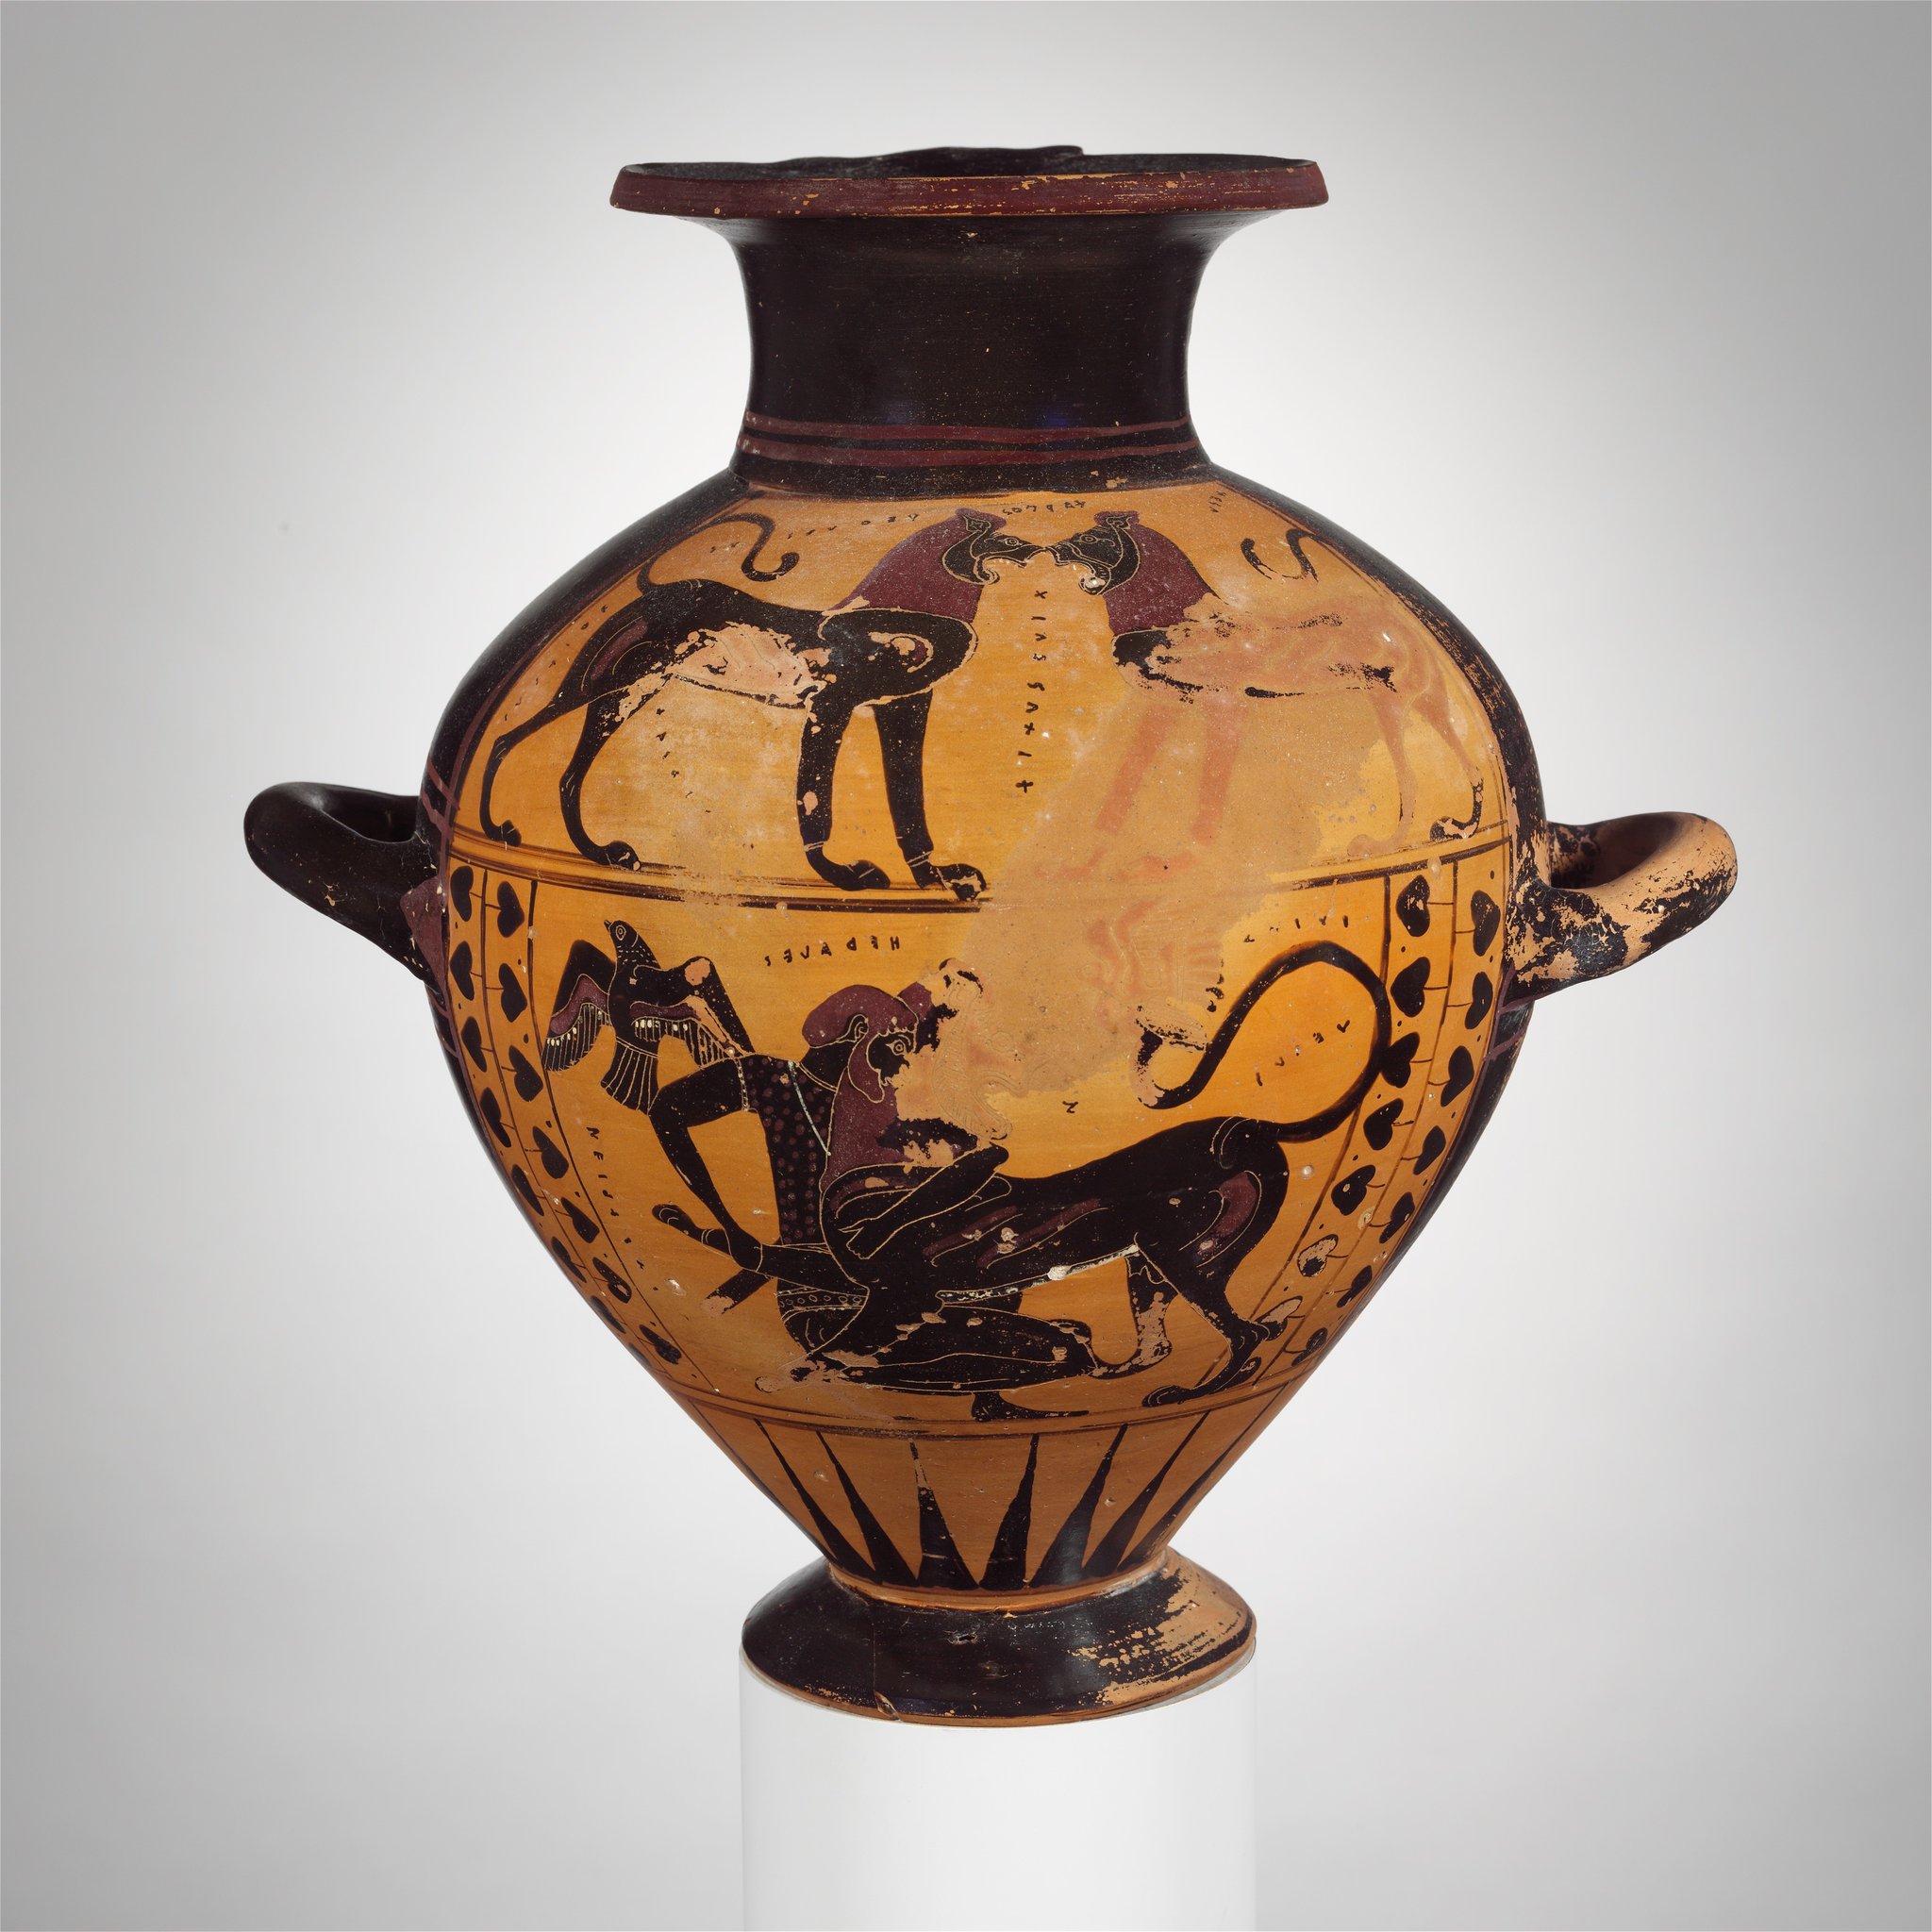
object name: hydria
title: Terracotta hydria (water jar)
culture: greek, attic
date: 575-551 BCE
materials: terracotta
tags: birds,lions,herakles